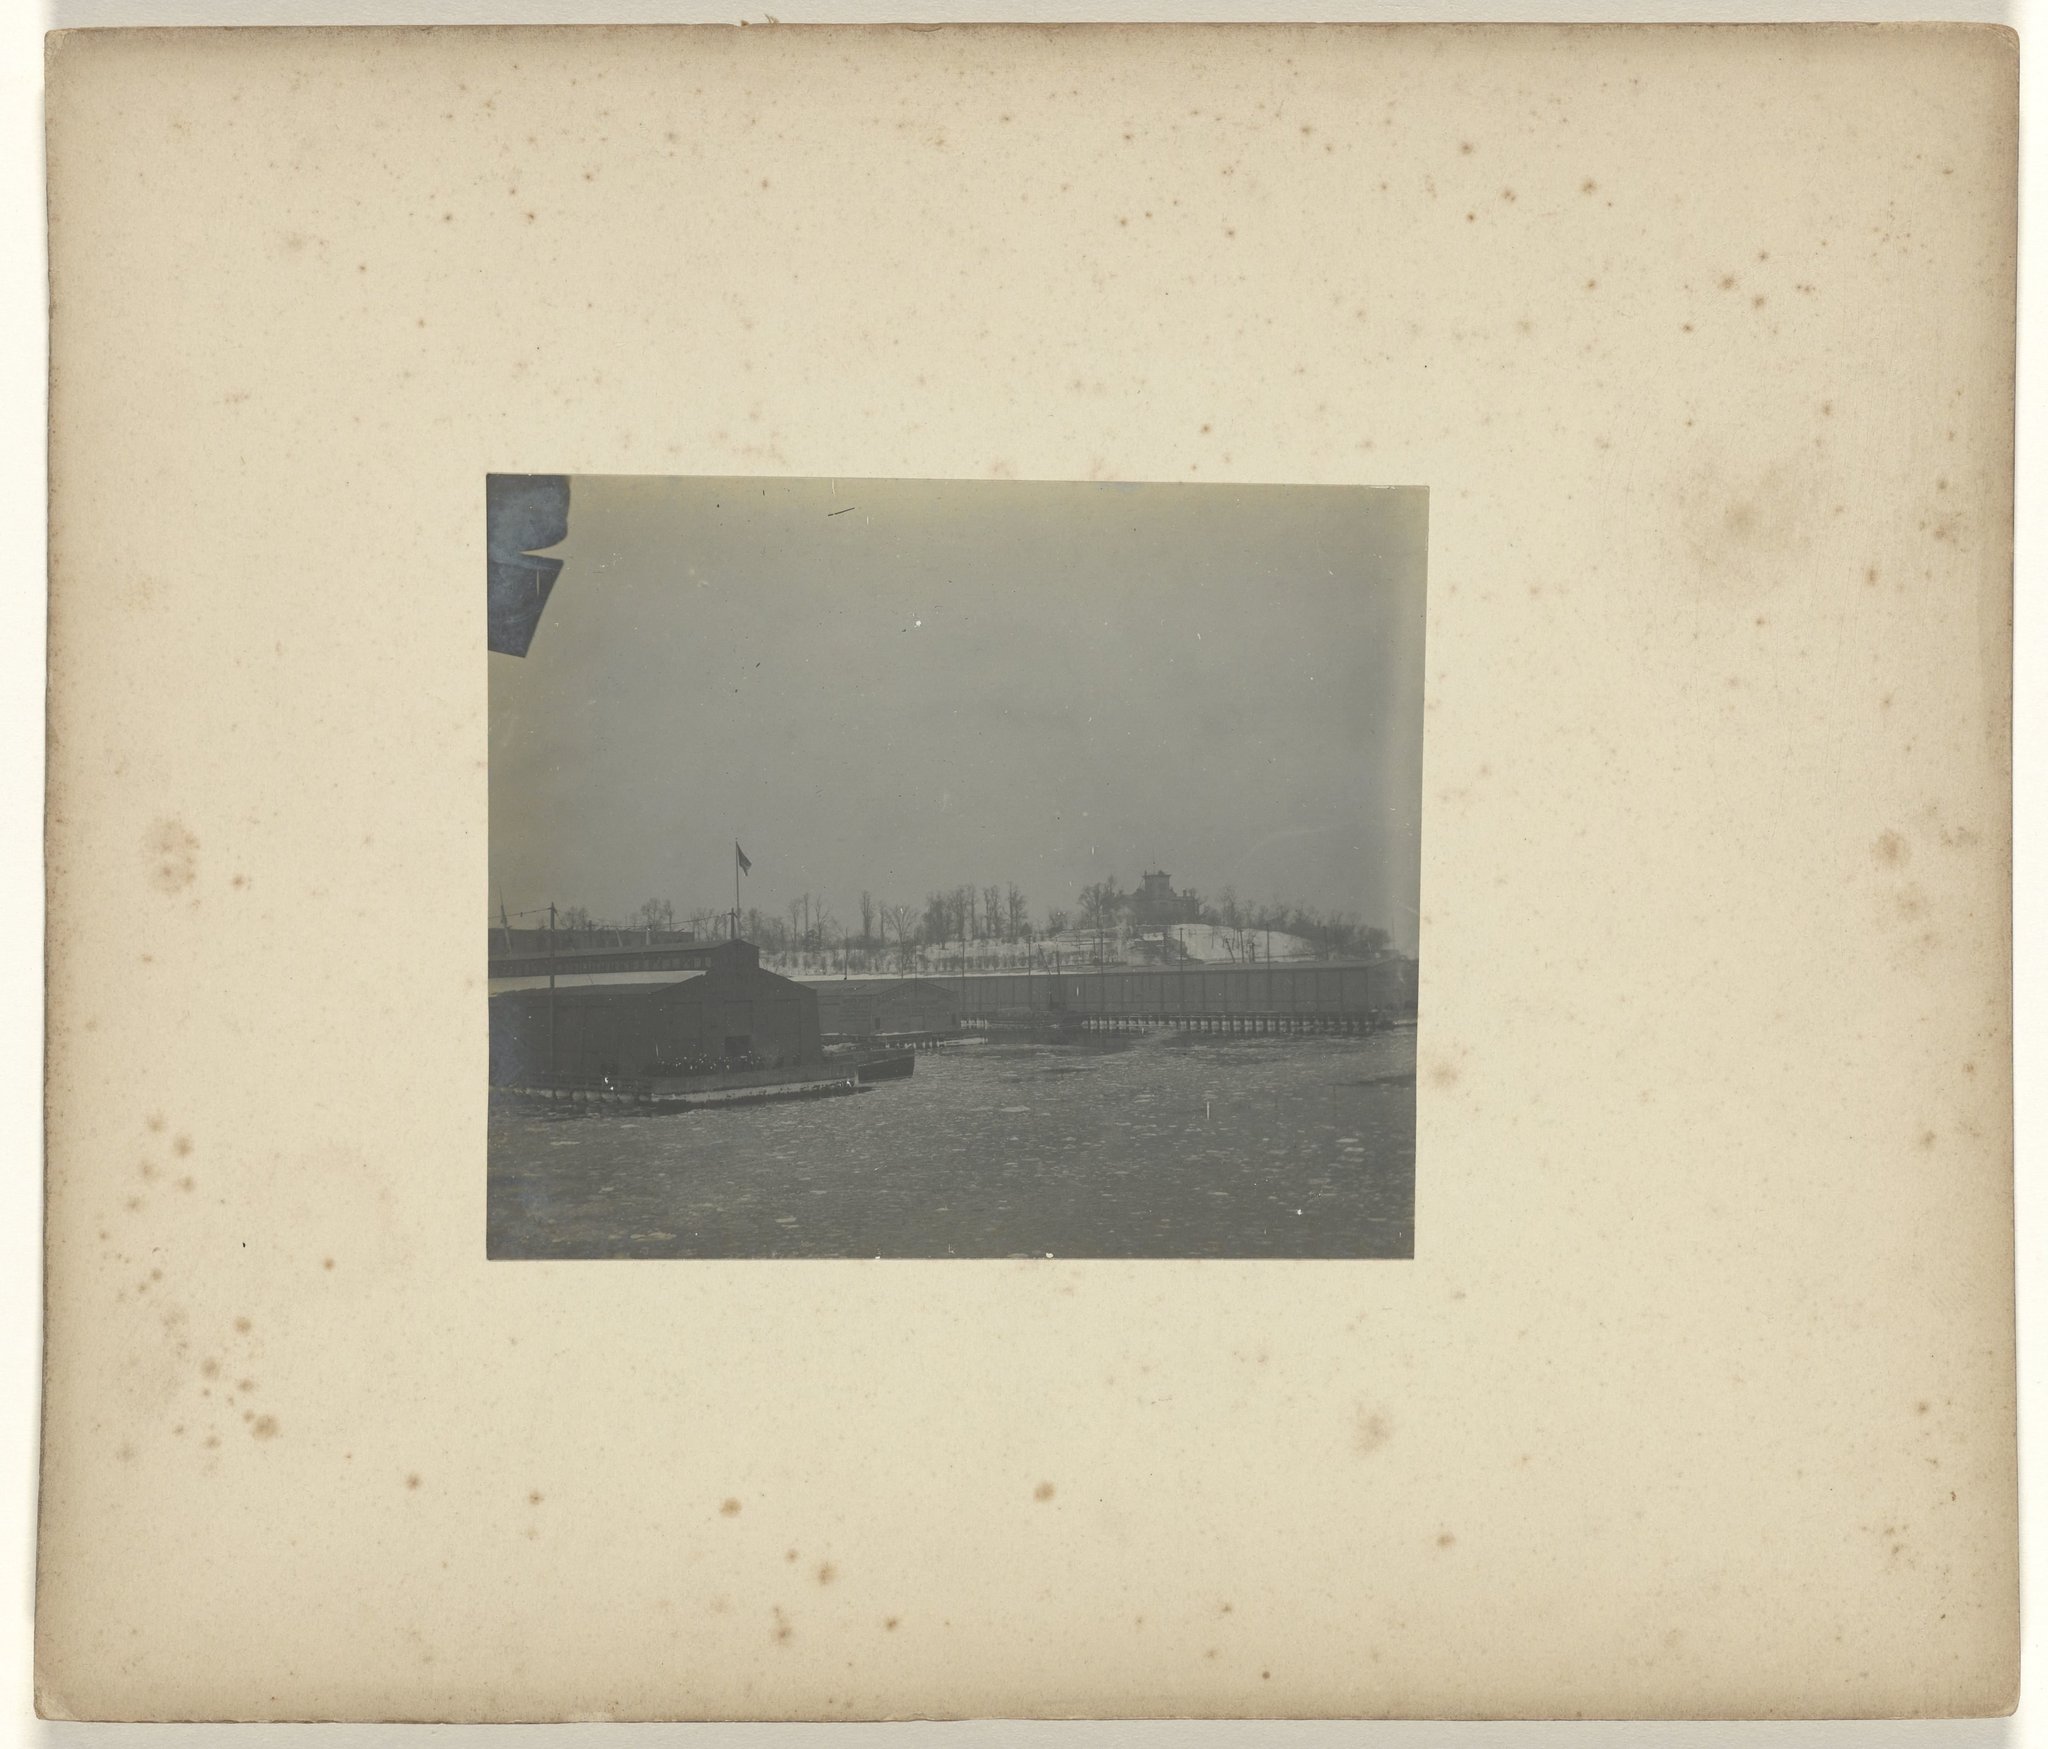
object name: photograph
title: Gezicht over het water, in of bij St. Louis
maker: jan schüller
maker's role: draughtsman, painter, print maker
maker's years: 1871-1915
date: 1904-1905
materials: cardboard, paper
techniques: gelatin silver print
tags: missouri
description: Gezicht over het water, in of bij St. Louis.